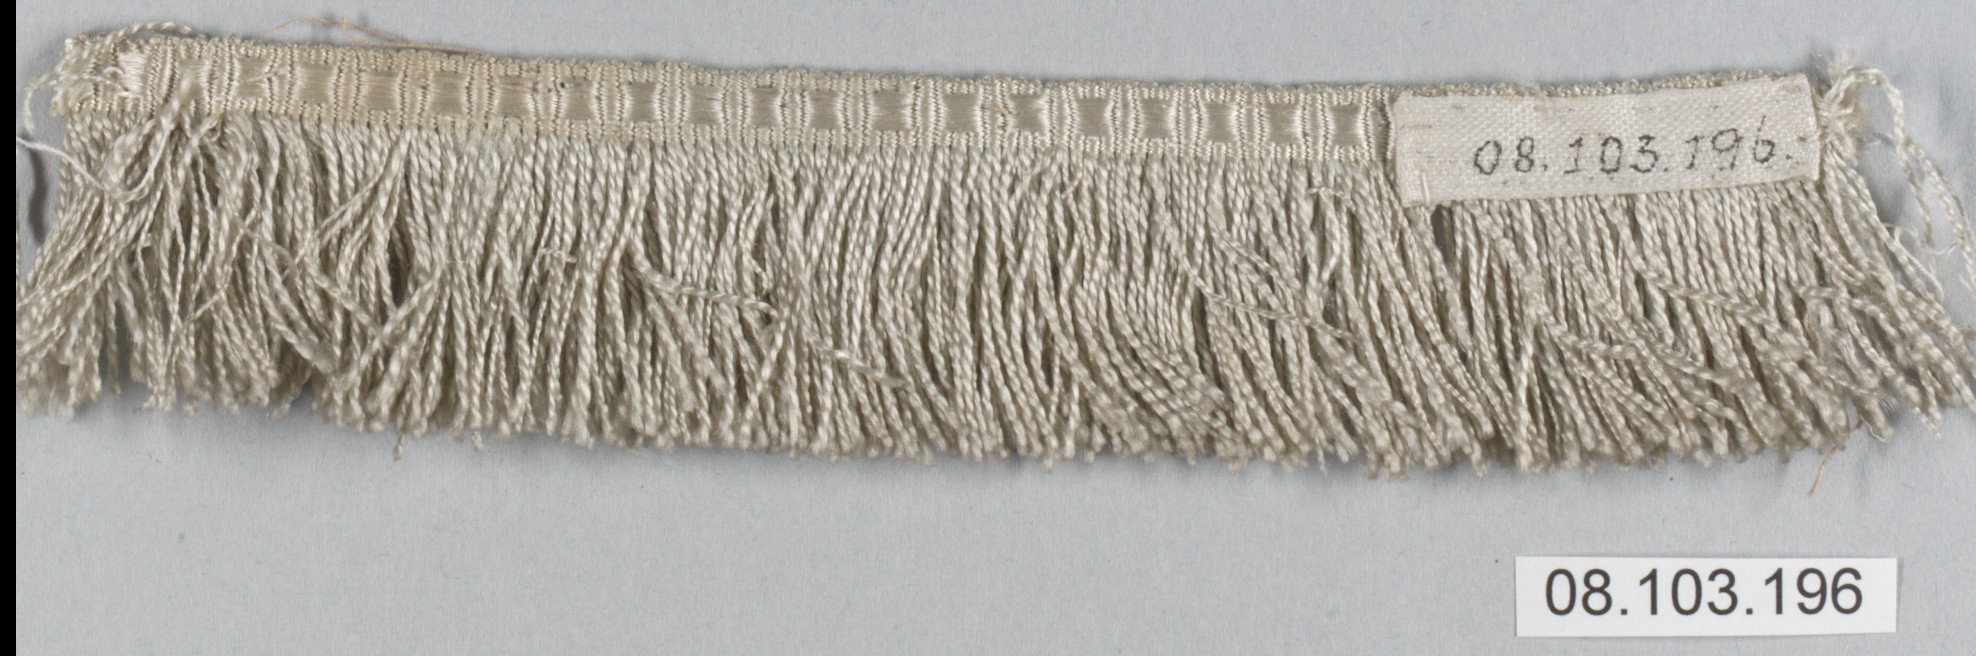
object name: fringe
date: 1801-1900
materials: silk